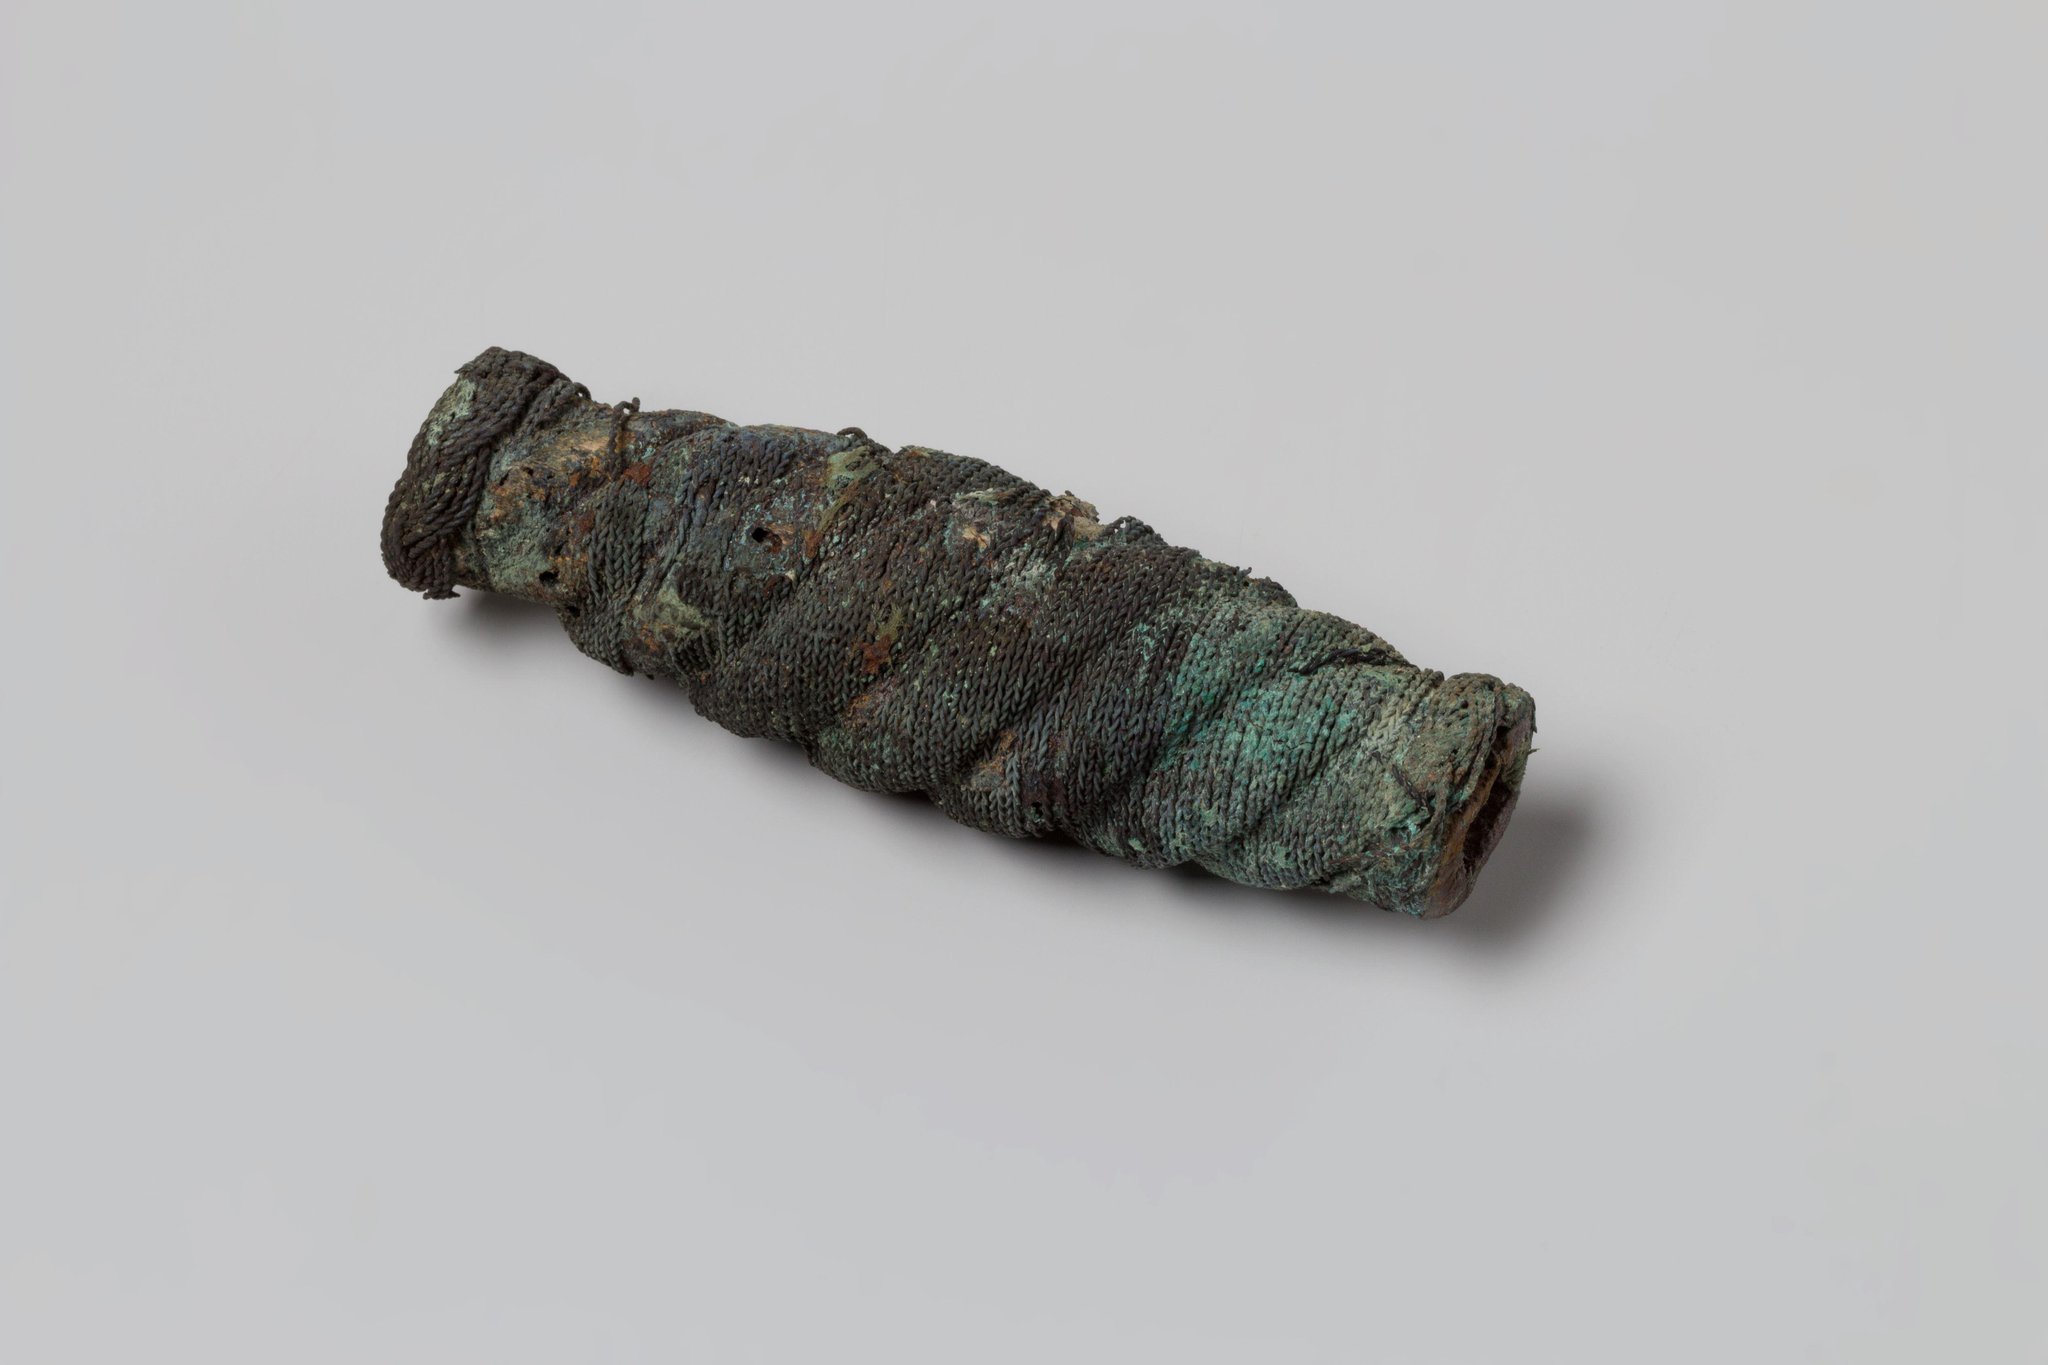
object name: hilt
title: Gevest van een zwaard uit het wrak van de in 1735 vergane Oost-Indiëvaarder 't Vliegend Hart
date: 1700-1735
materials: copper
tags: 't vliegend hart (schip), verenigde oostindische compagnie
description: Gevestvan een zwaard, omwikkeld met koperdraad dat groen-blauw is verkleurd als gevolg van oxidatie. Ronde doorsnede, langwerpig, rondom de 'basis' zitten gedraaide koperdraden. Swordhandle.